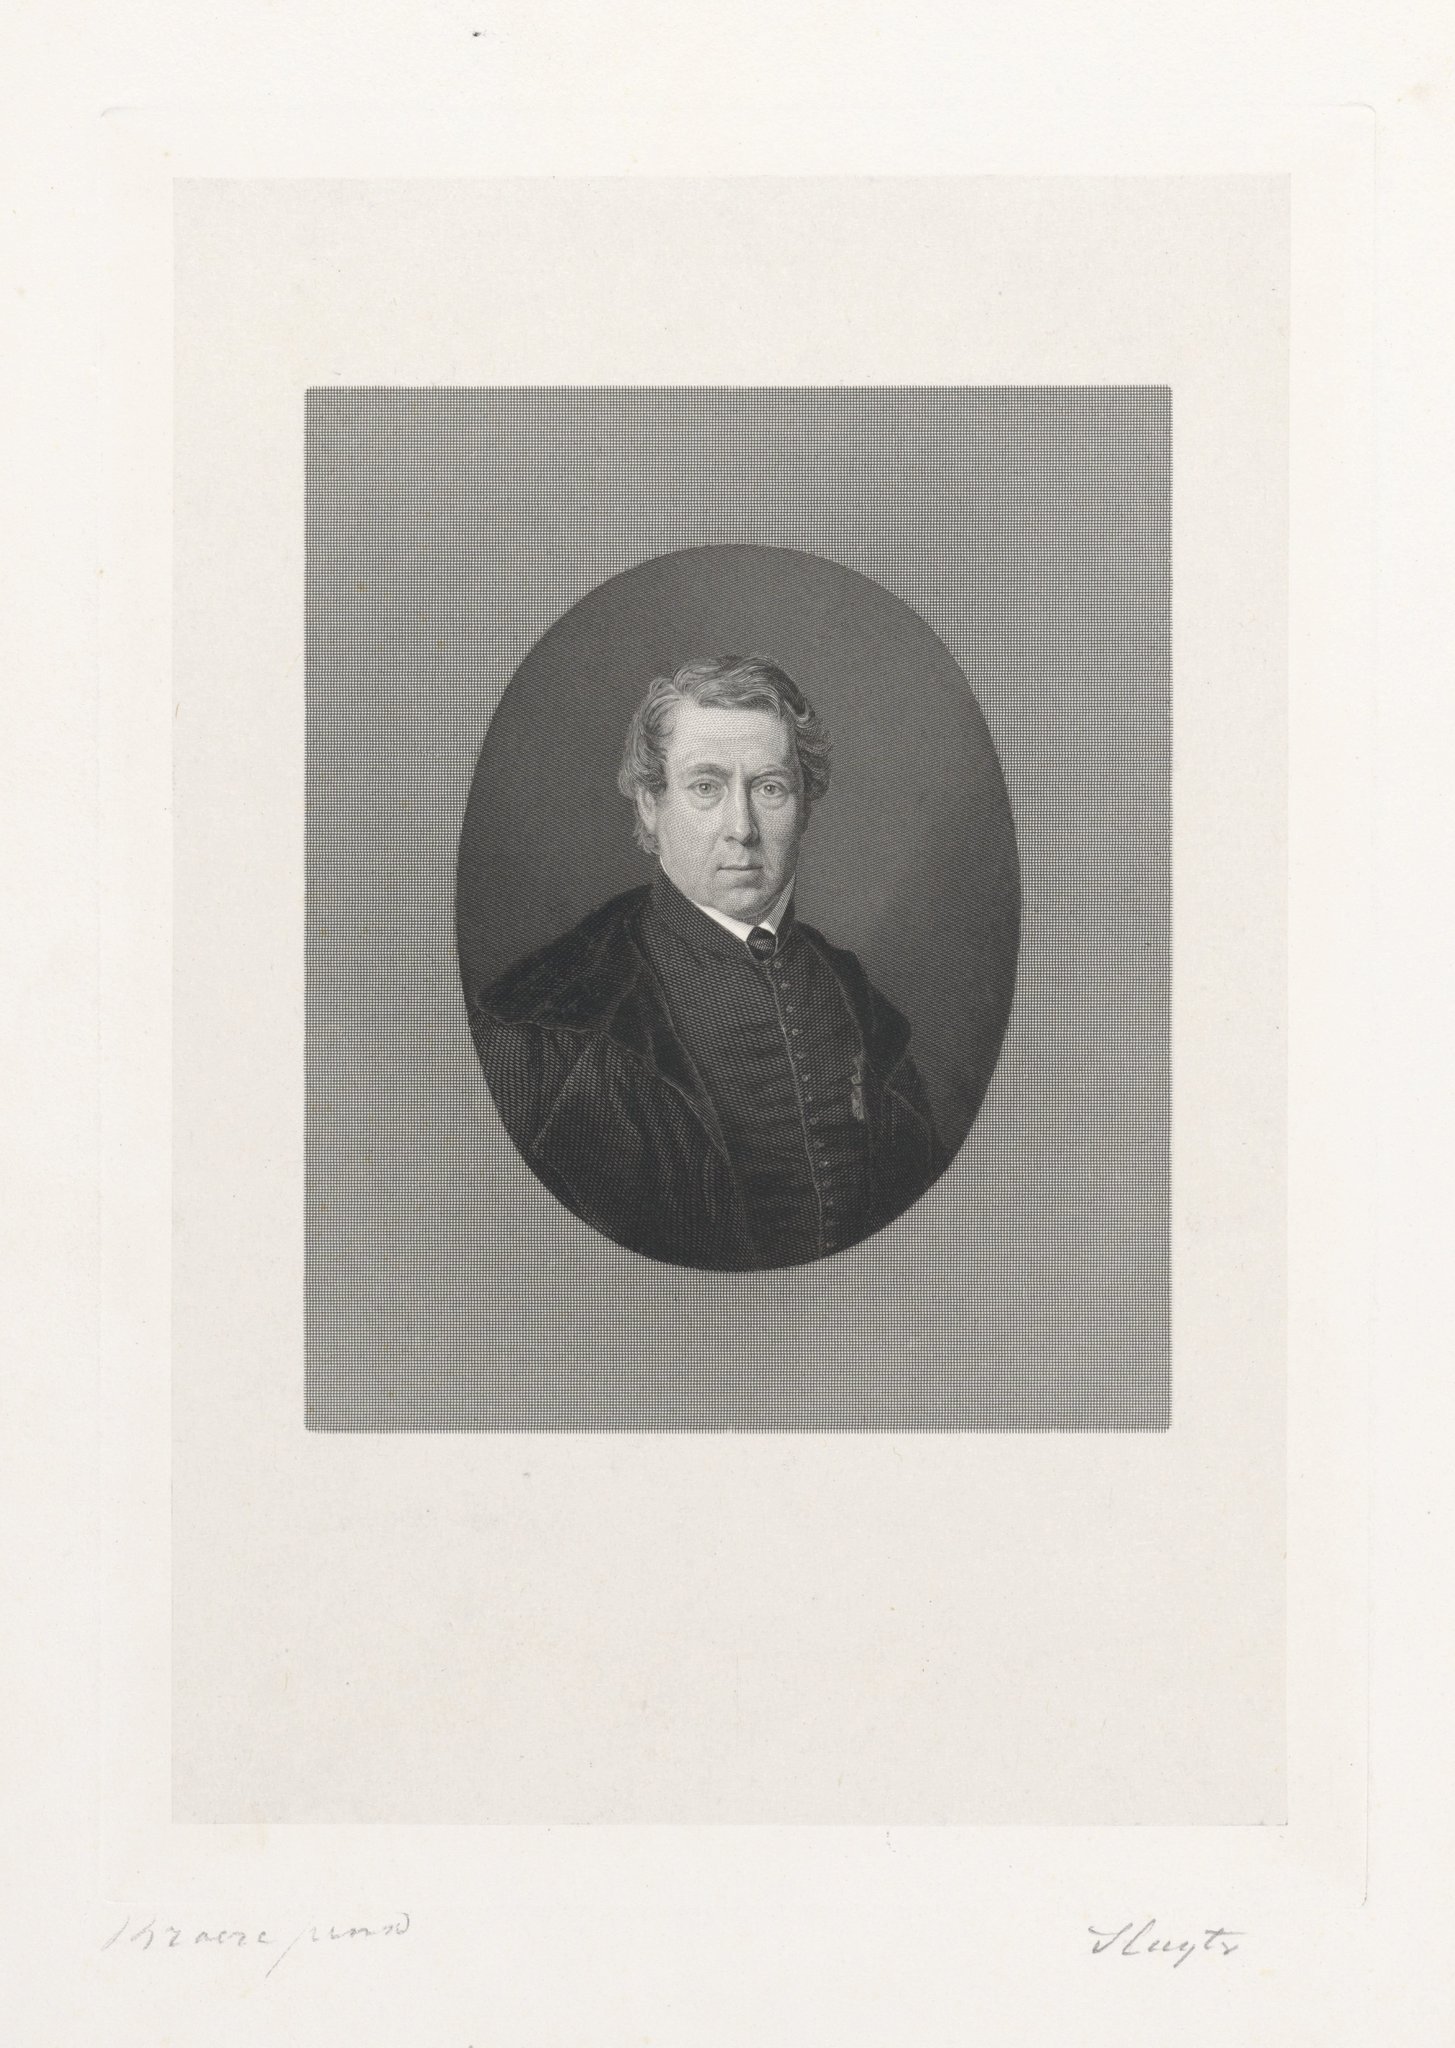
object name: print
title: Portret van de schilder en theoloog Cornelis Broere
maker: dirk jurriaan sluyter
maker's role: draughtsman, print maker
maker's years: 1811-1886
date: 1860-1879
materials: paper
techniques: etching, engraving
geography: amsterdam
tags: warmond, painter, cornelis broere, portrait, self-portrait of painter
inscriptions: collector's mark: Lugt 12